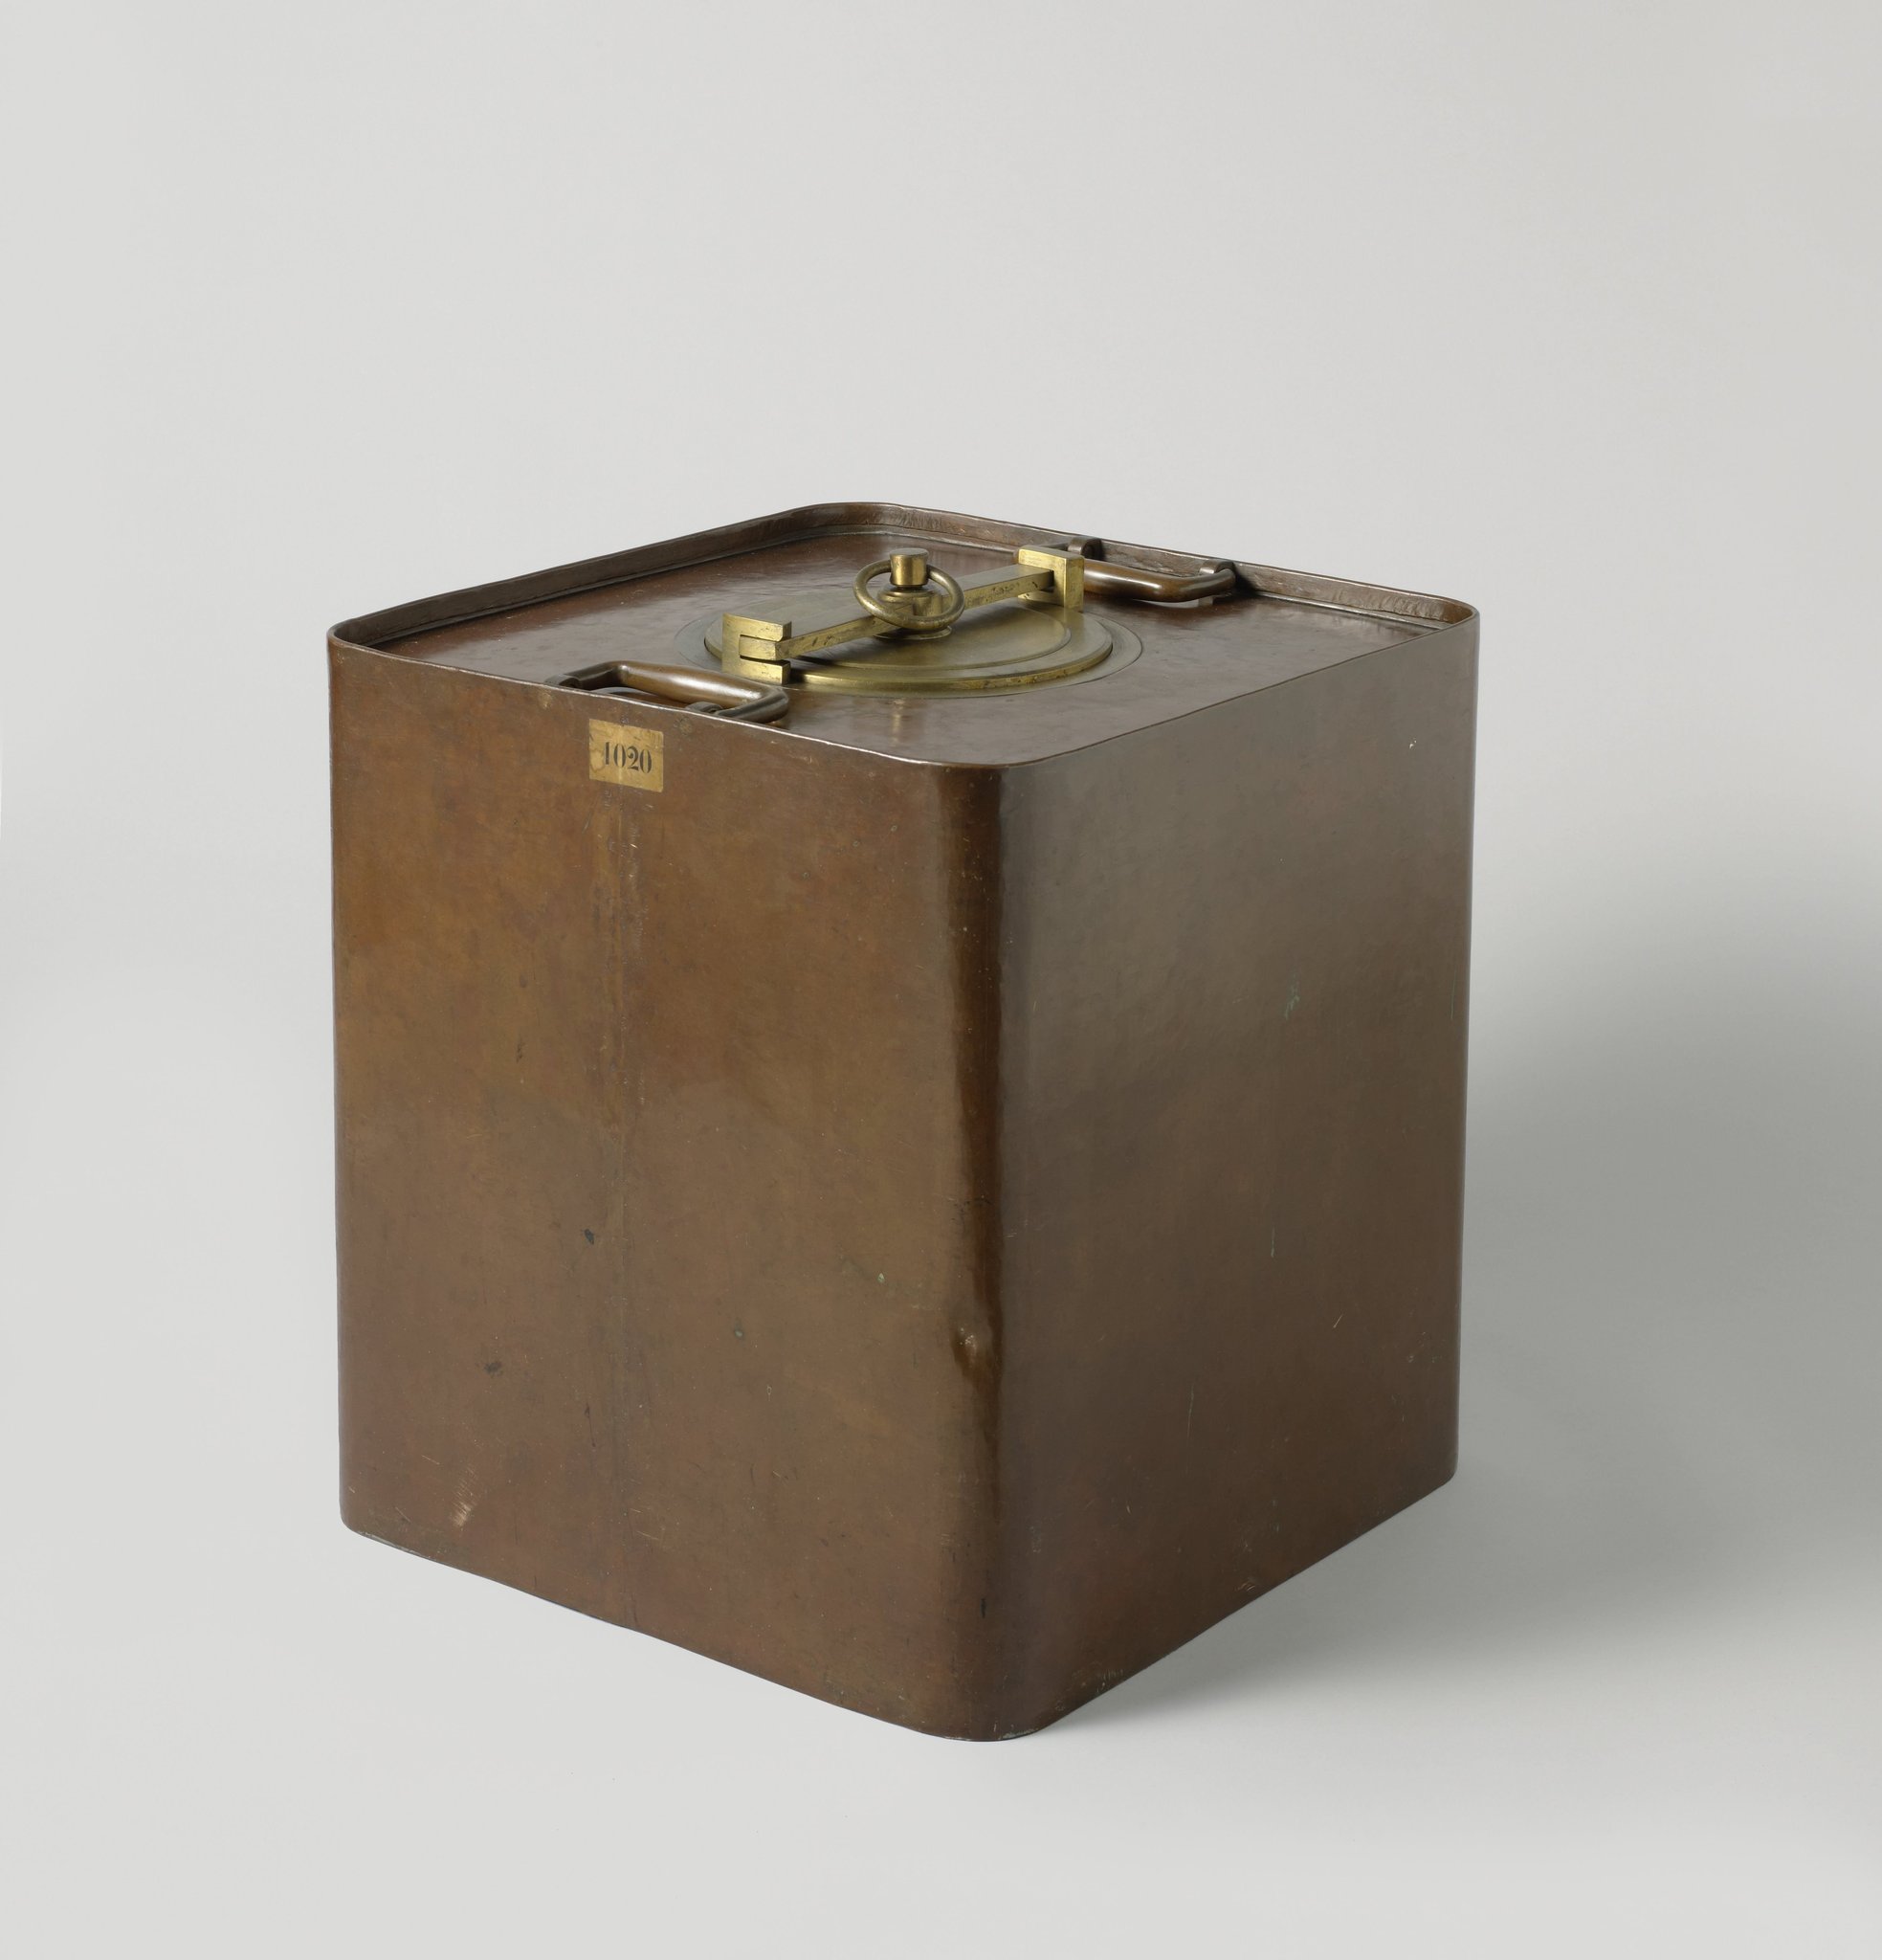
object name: chest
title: Powder Chest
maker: Anonymous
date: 1859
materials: brass, copper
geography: netherlands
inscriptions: label, top centre: ‘1020’ former inventory label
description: Vierkant koperen kruitkist met twee handvaten en een rond deksel. Het deksel is voorzien van een wervelsluiting, bestaande uit een messing staaf die draait om een bout in het midden van het deksel en zich onder twee nokken op de buitenrand van de opening vastklemt; met de bout wordt hij vervolgens aangedraaid.